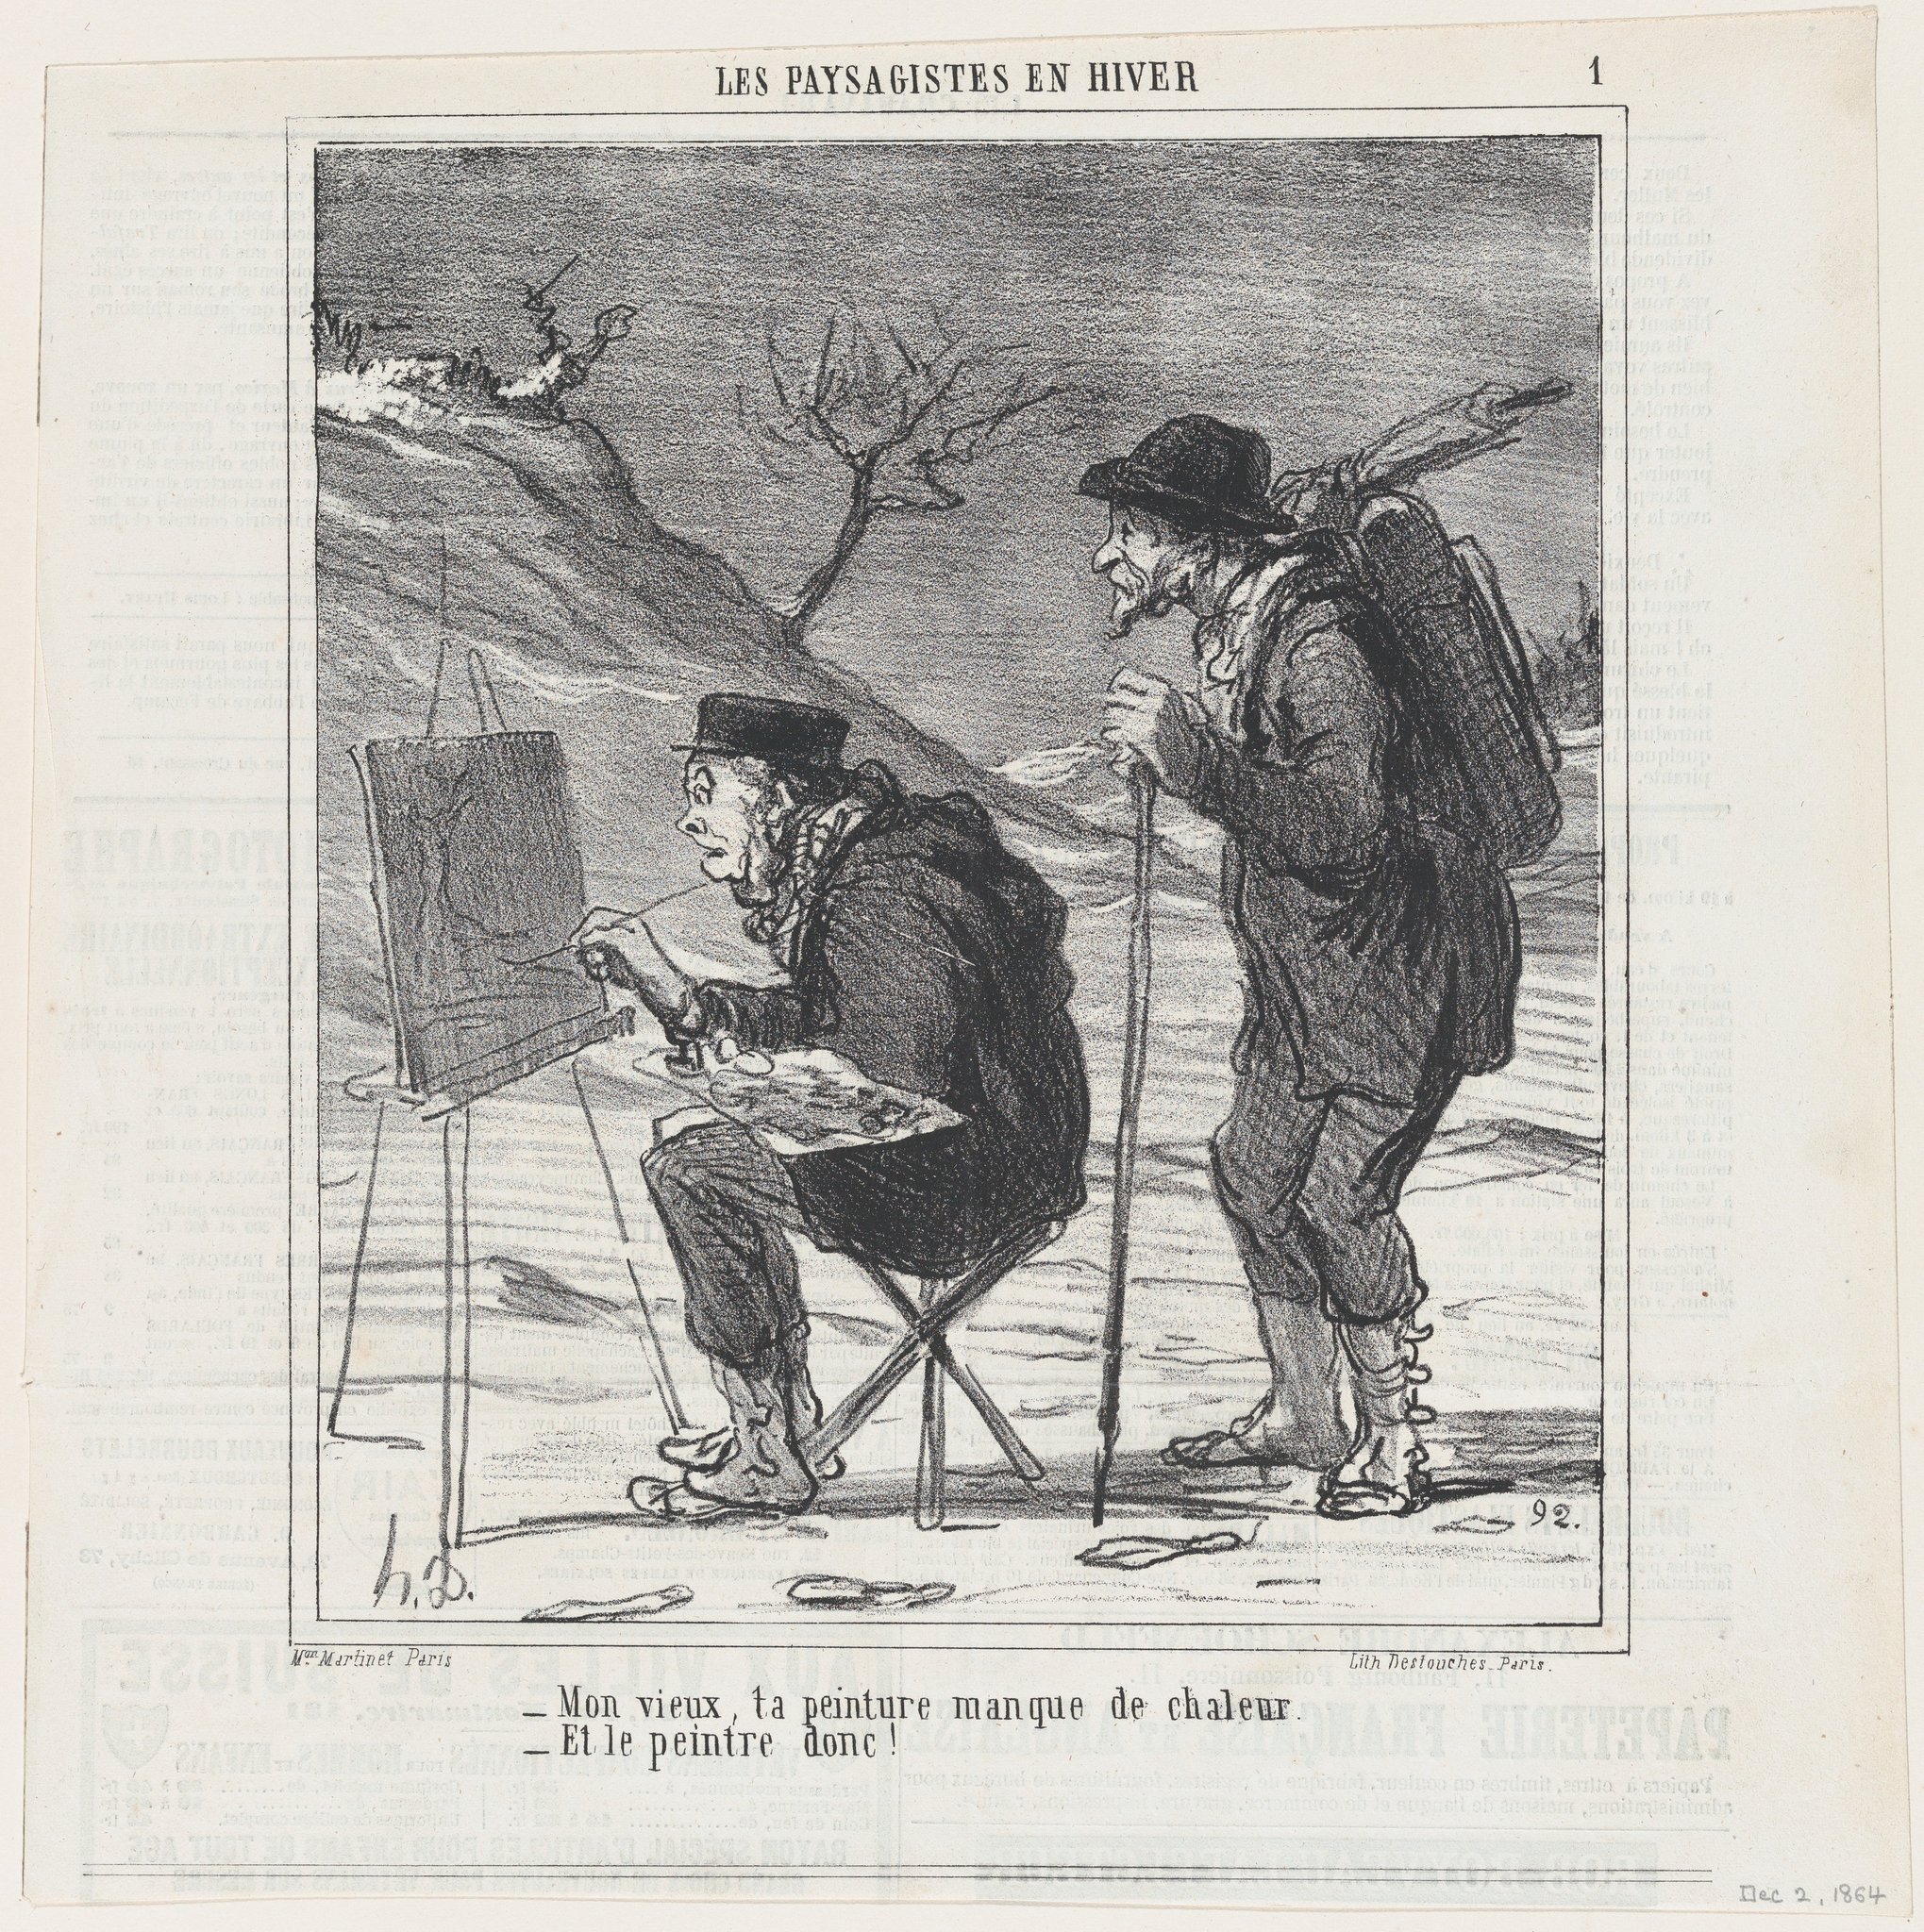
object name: print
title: Old fellow, your painting lacks warmth, and the painter to be sure!, from 'The winter landscape painters,' published in Le Charivari, December 6, 1864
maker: honoré daumier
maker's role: artist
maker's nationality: french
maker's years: 1808-1879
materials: paper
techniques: lithograph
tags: painting,men